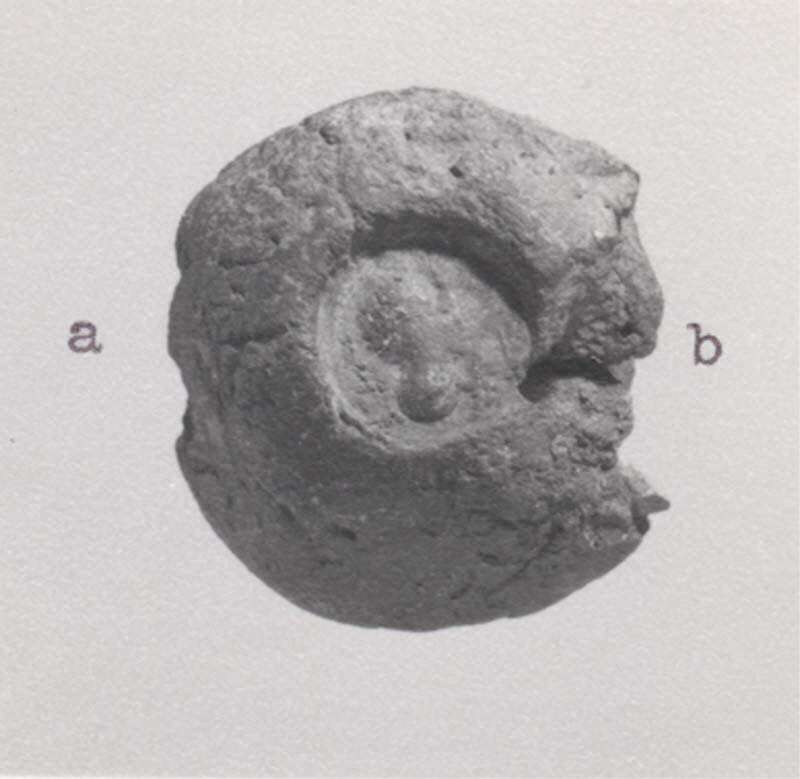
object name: sealing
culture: sasanian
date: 601-700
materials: clay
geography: iran